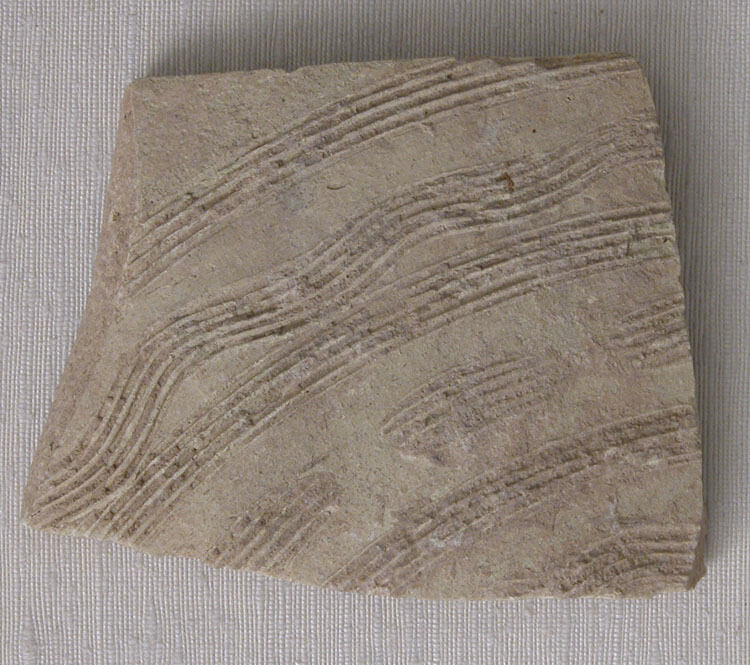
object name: fragment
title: Ceramic Fragment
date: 701-900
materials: earthenware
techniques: incising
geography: iraq